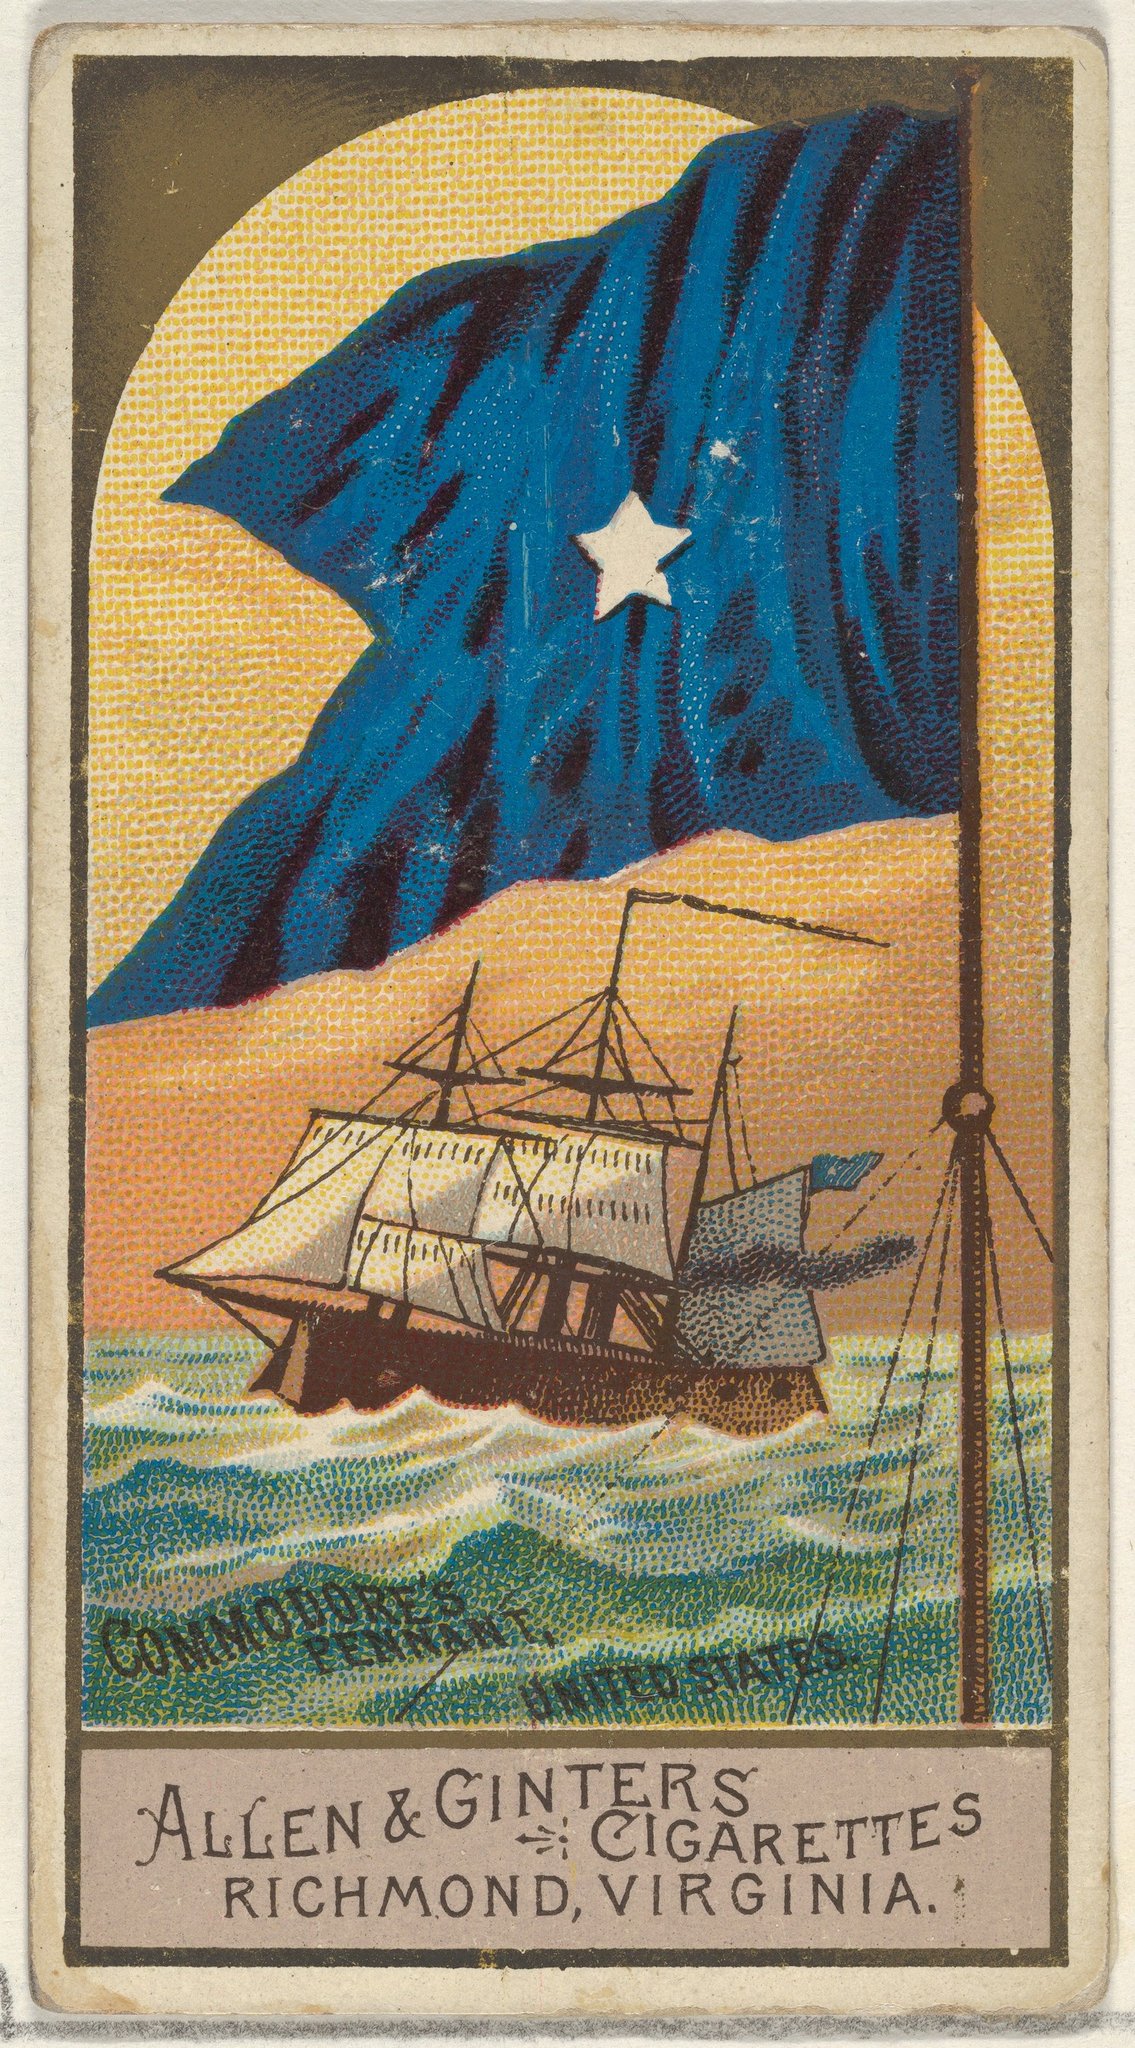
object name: print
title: Commodore's Pennant, United States, from the Naval Flags series (N17) for Allen & Ginter Cigarettes Brands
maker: allen & ginter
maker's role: publisher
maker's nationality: american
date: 1888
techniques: color lithograph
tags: flags,ships